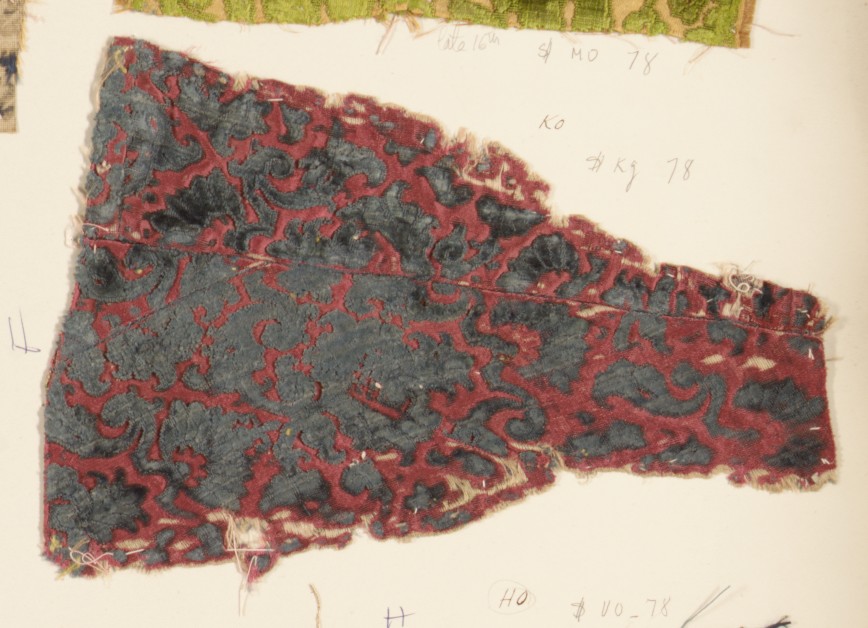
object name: fragment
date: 1501-1600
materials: silk